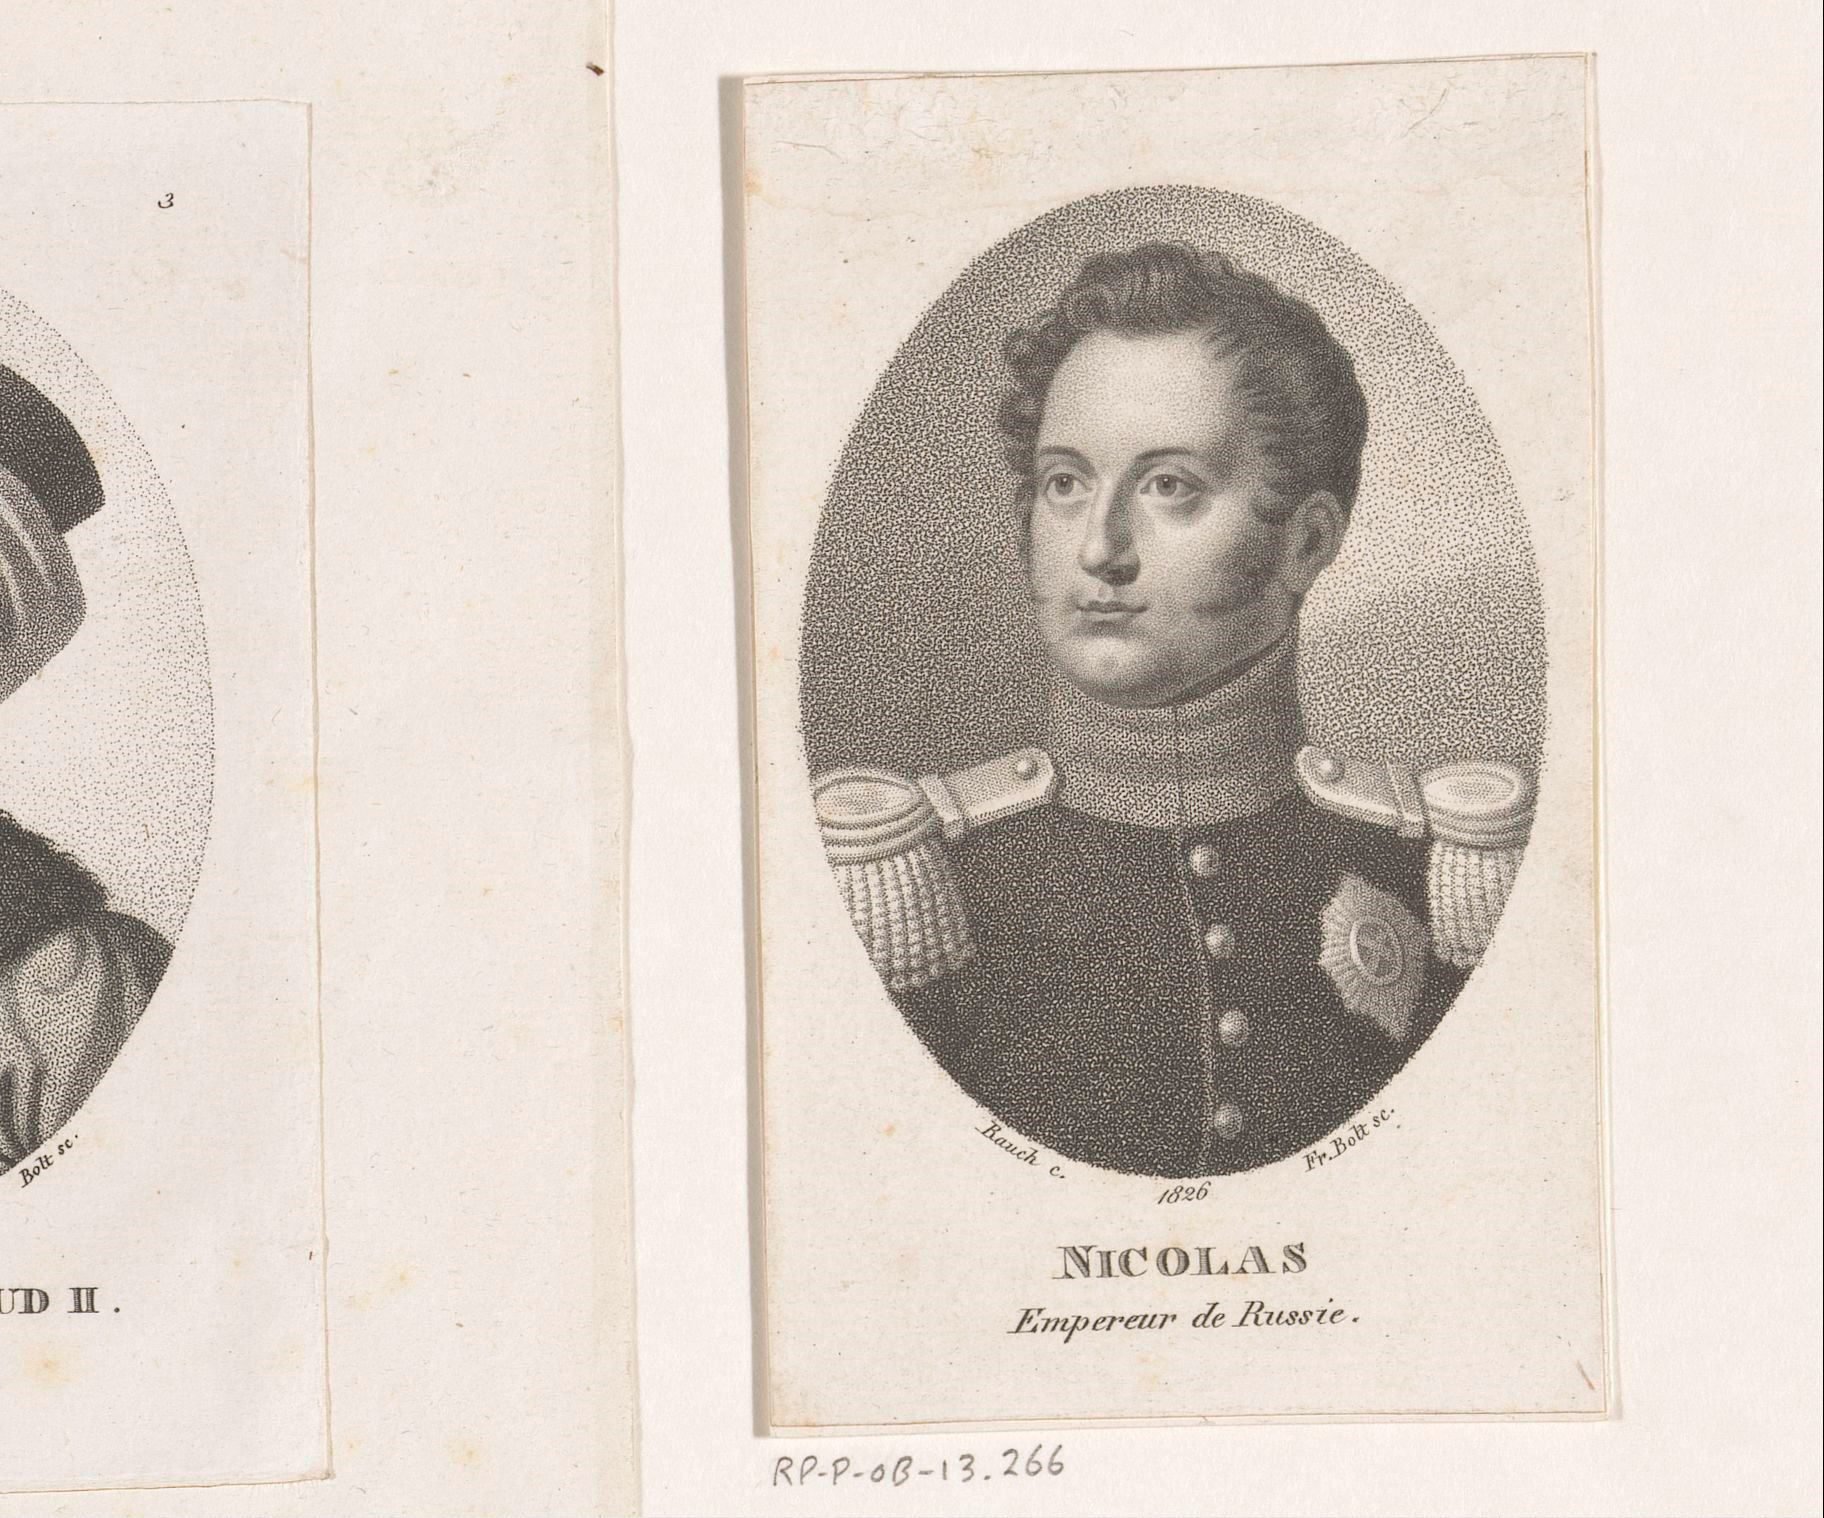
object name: book illustration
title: Portret van Nicolaas I Pavlovitsj, tsaar van Rusland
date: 1826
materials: paper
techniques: stippling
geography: berlin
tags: knighthood order, historical persons, (military) uniforms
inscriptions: collector's mark: Lugt 2228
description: Prent afkomstig uit: Almanach de Gotha, 1827.